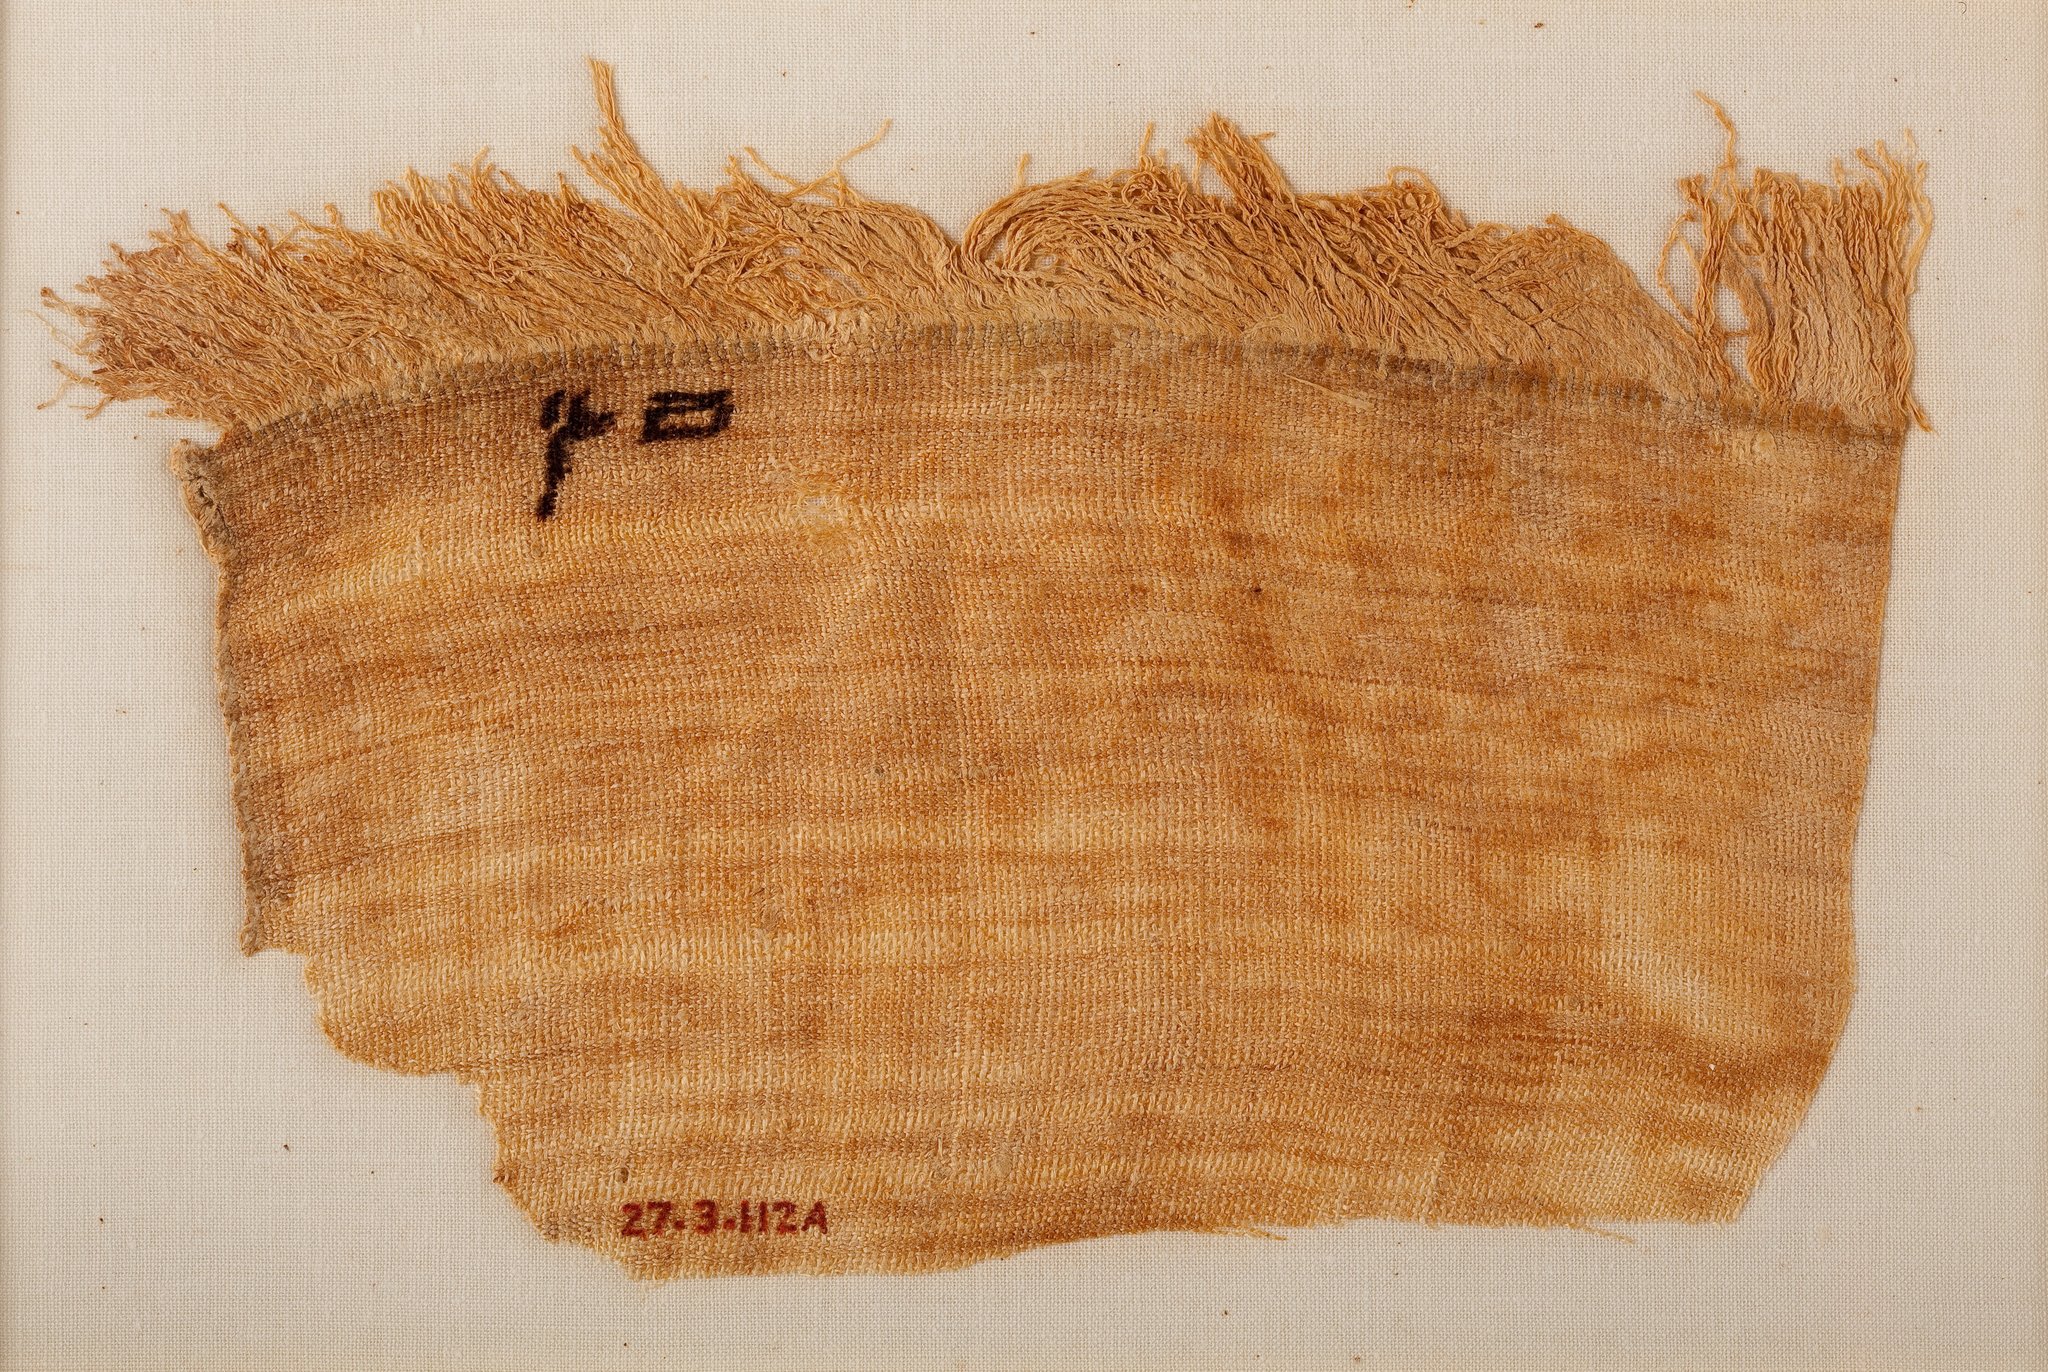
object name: linen mark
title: Linen mark (Type XIV)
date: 1961-1917 BCE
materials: linen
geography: egypt